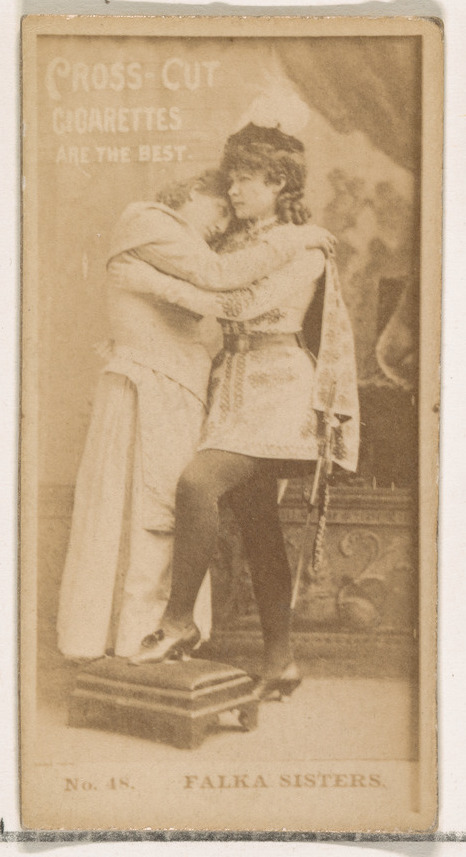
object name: print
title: Card Number 48, Falka Sisters, from the Actors and Actresses series (N145-2) issued by Duke Sons & Co. to promote Cross Cut Cigarettes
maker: w. duke, sons & co.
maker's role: publisher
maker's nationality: american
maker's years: 1870-1920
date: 1880-1889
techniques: albumen silver print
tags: portraits,women,actresses